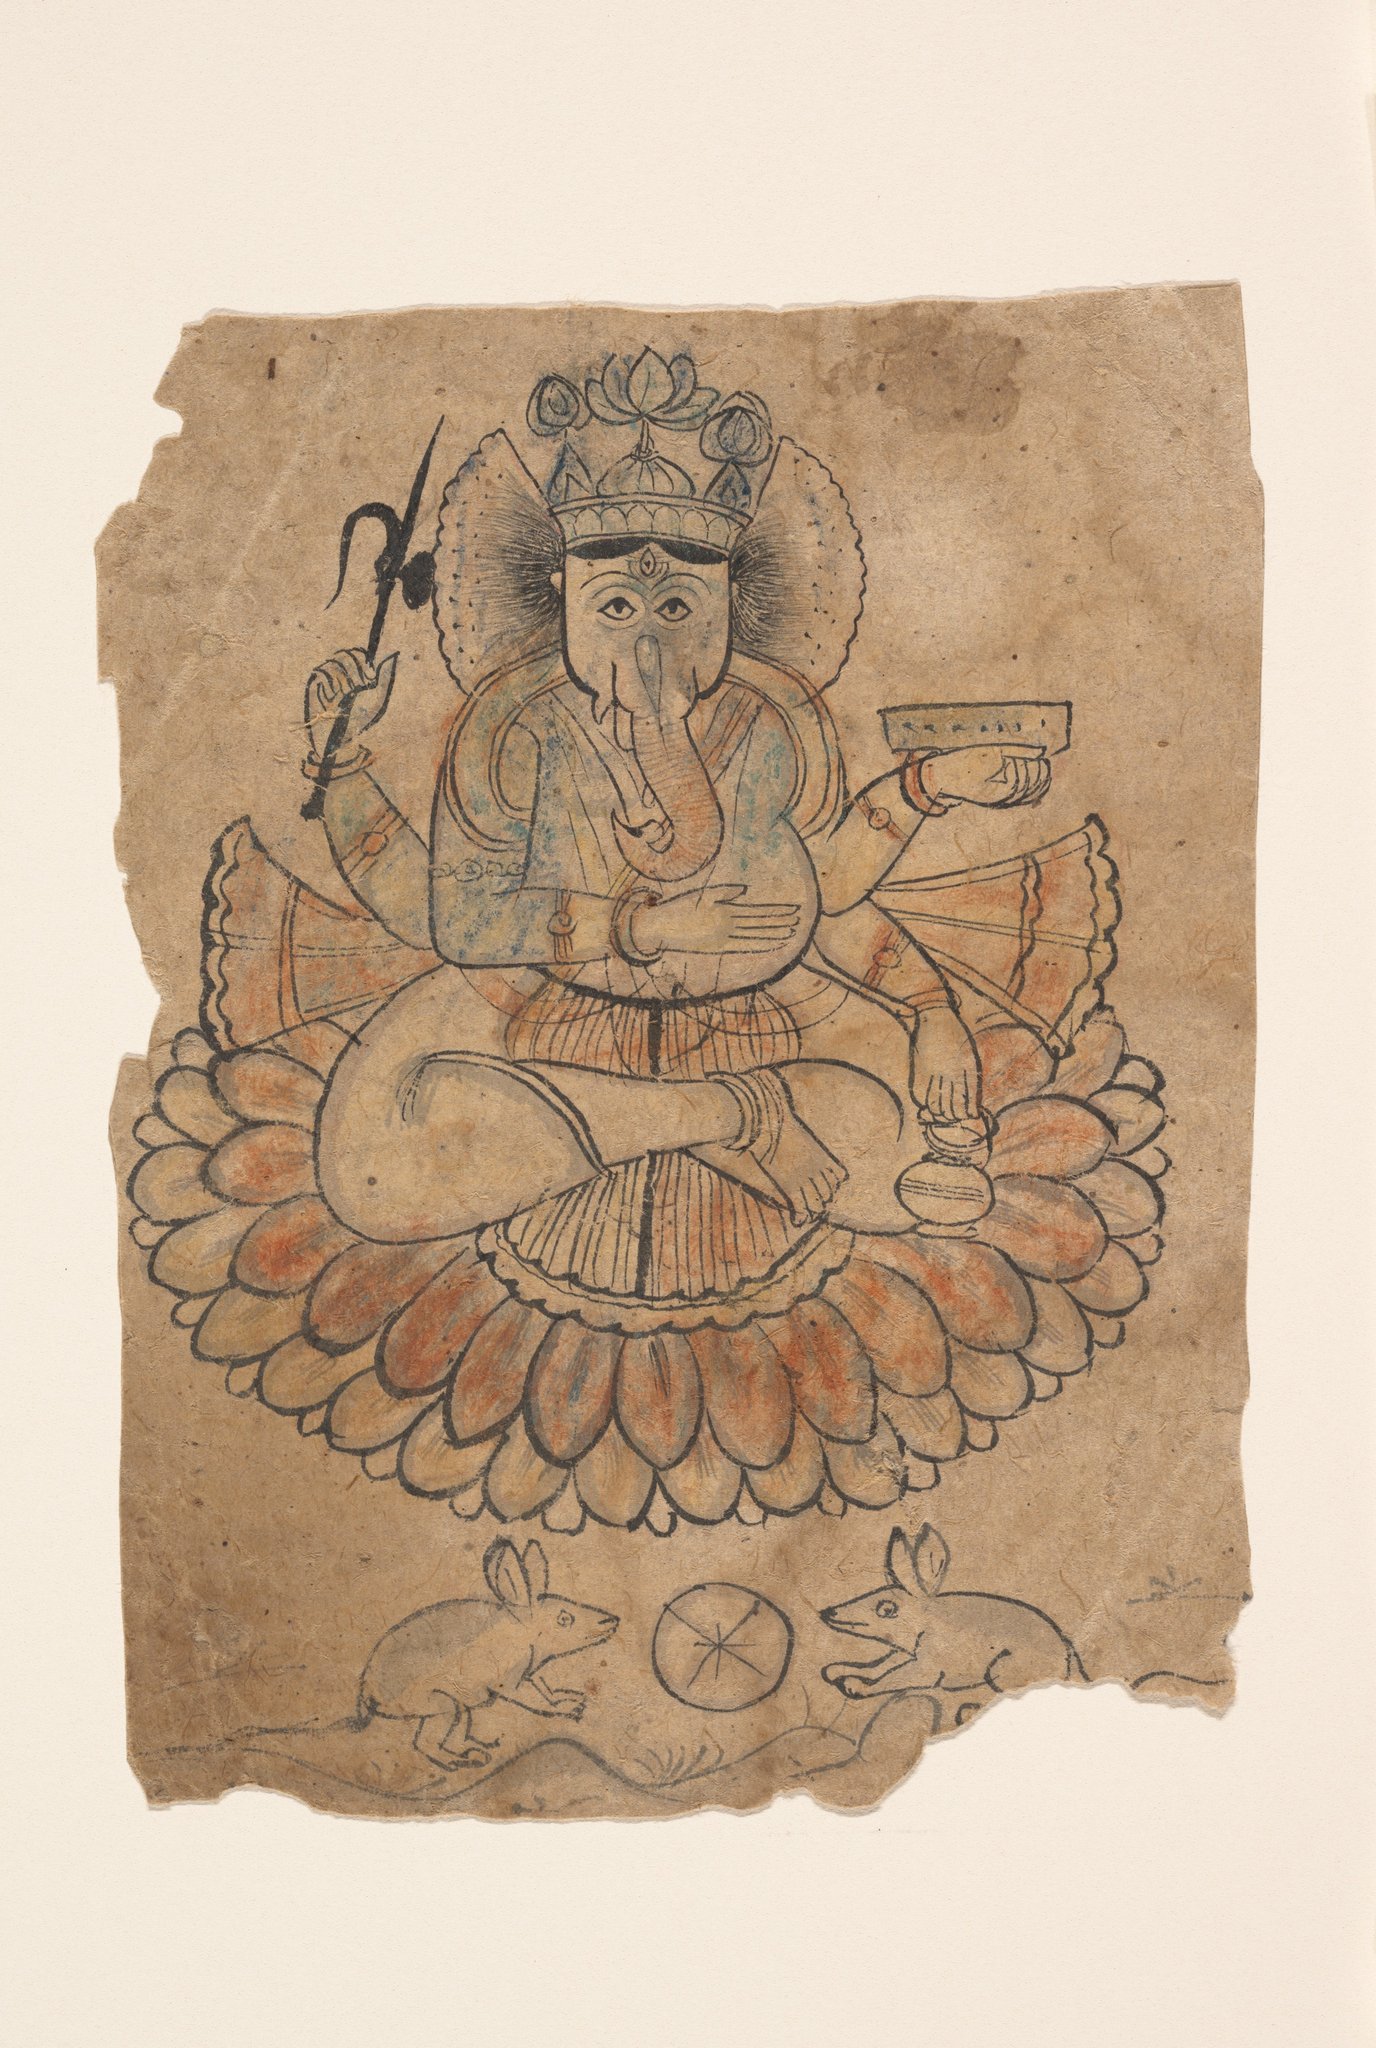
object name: painting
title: Seated Four-Armed Ganesha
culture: indian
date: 1775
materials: ink, paper, watercolor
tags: rats,ganesha